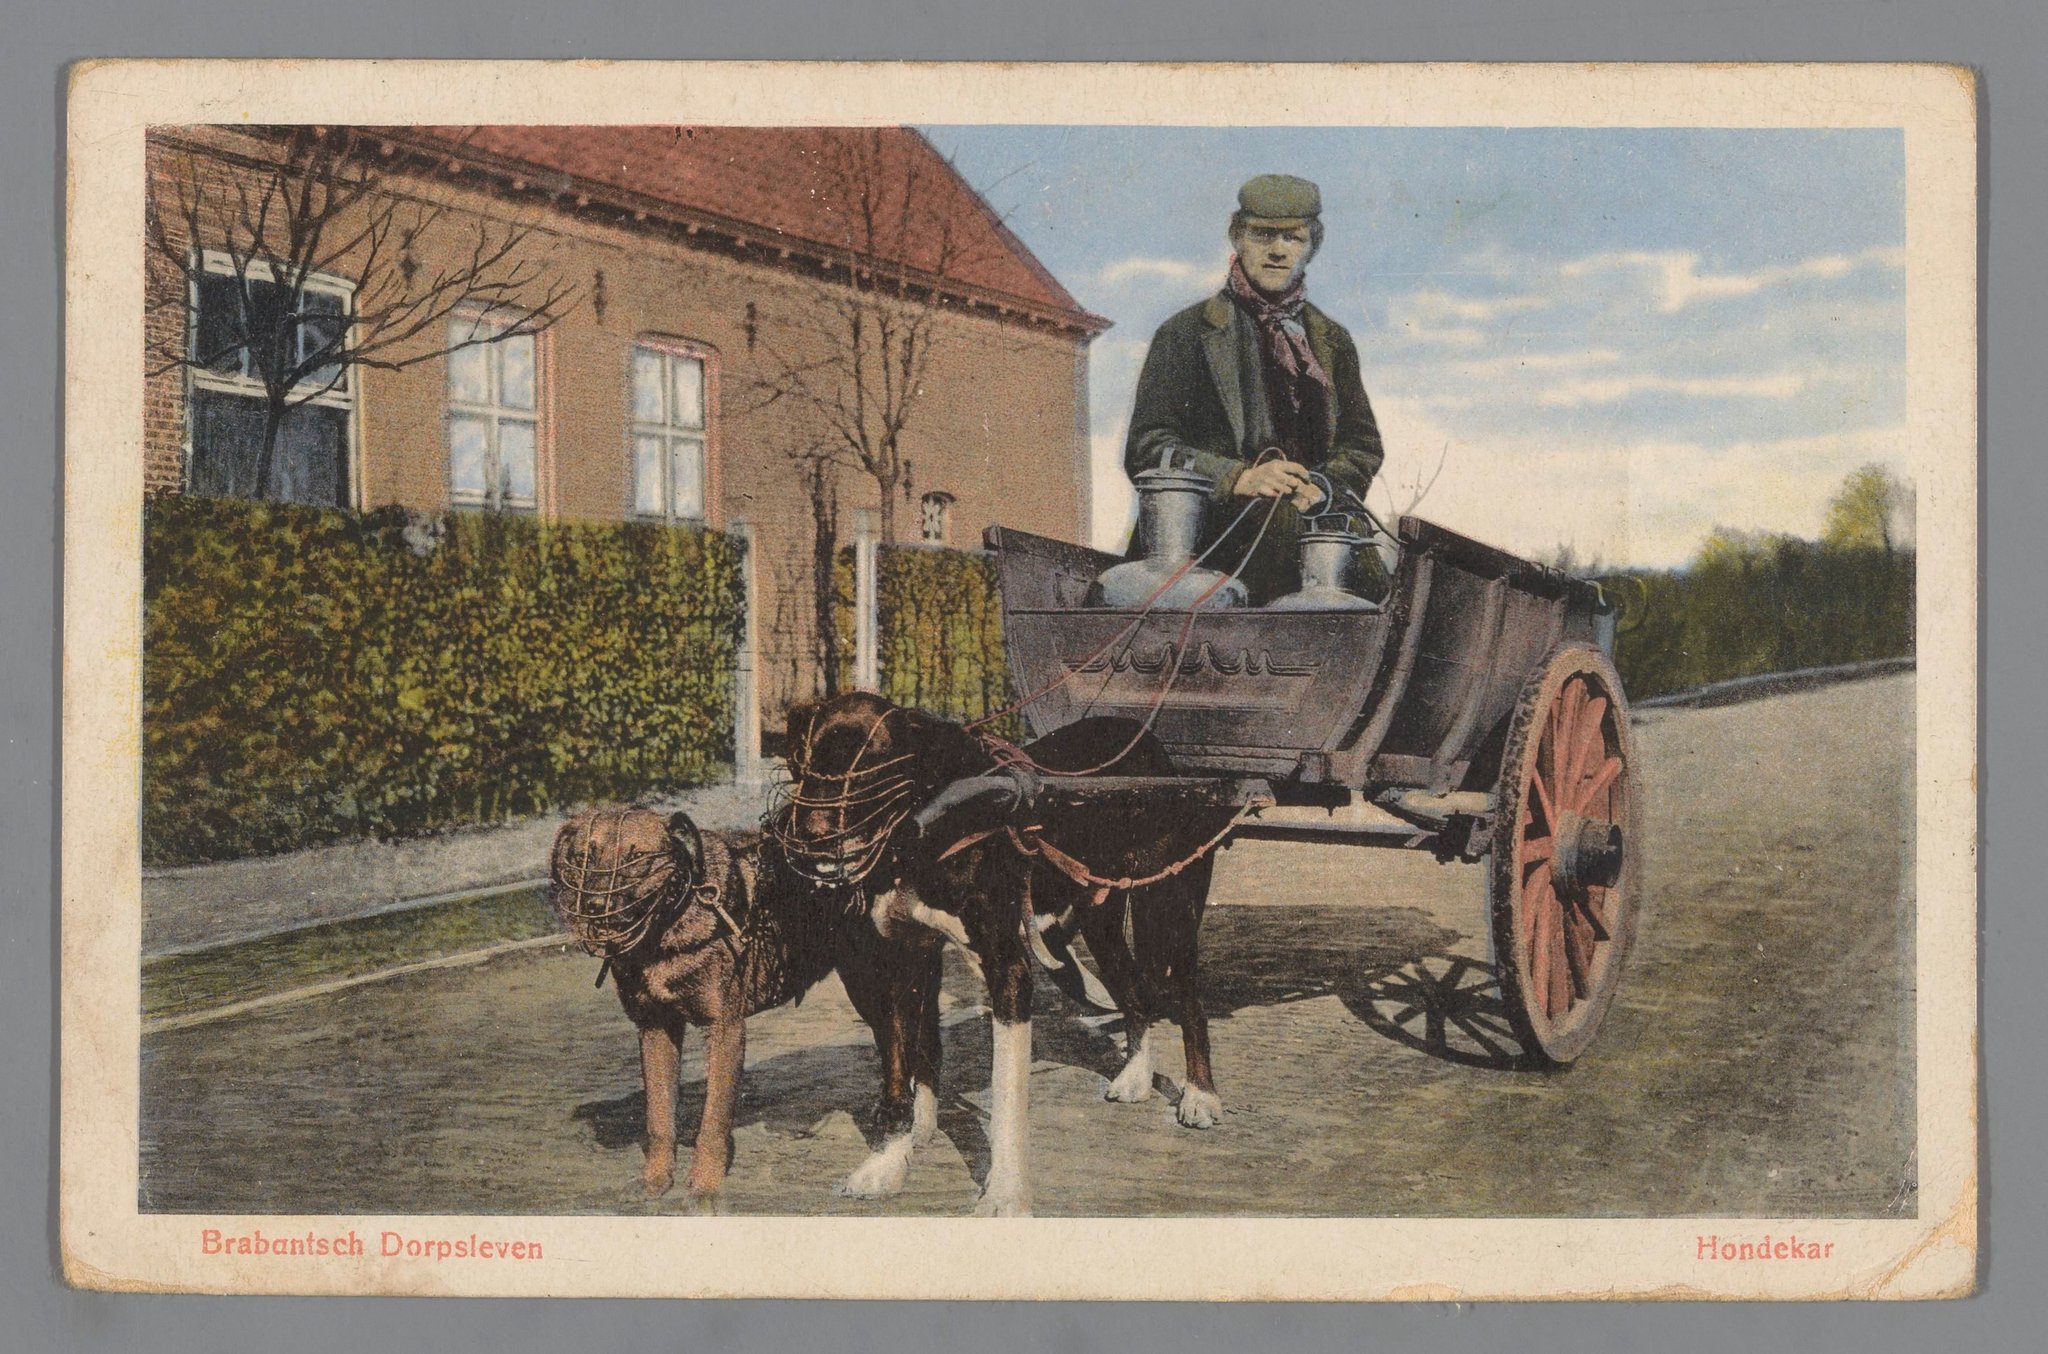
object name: ansichtkaart, prentbriefkaart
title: Brabantsch Dorpsleven - Hondekar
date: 1918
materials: cardboard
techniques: photograph, lithograph, writing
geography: amsterdam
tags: two-wheeled vehicle drawn by one animal (+ one person ~ traffic and transport), dog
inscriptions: inscription: ‘J. H. Schaefer's Fotocoleur, Amsterdam B 517/17 Nadruk verboden’